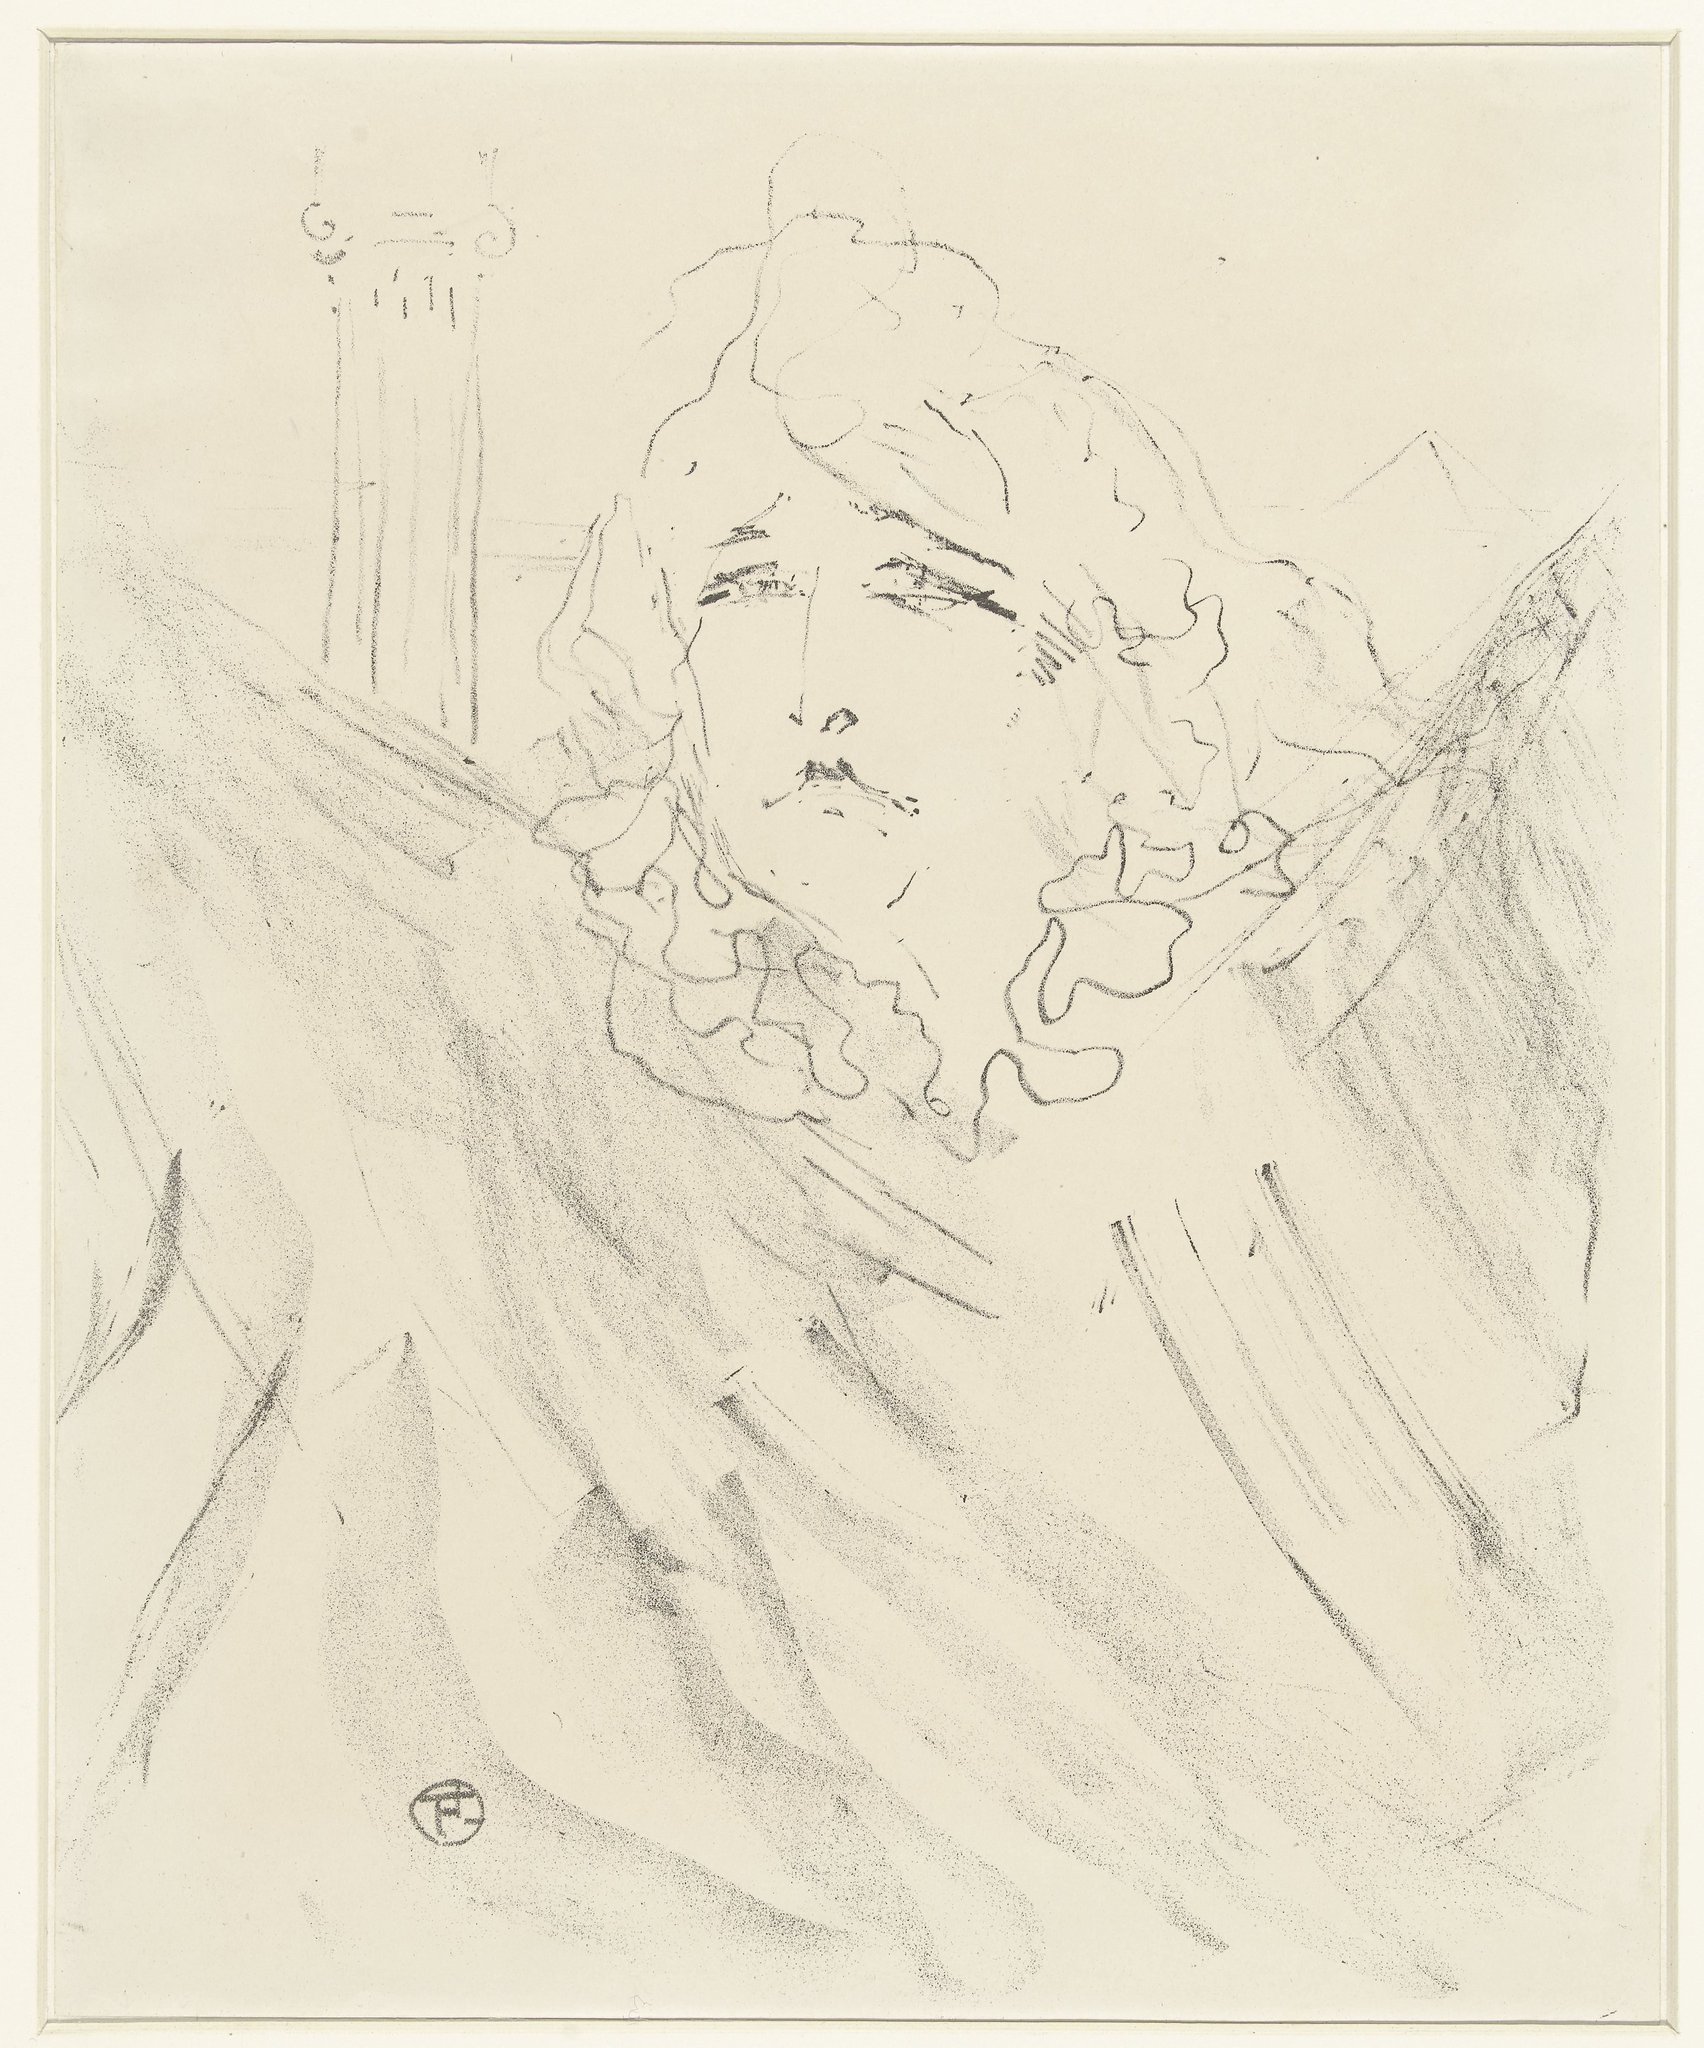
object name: print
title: Portret van actrice Sarah Bernhardt in Cleopâtre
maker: henri de toulouse-lautrec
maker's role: draughtsman, painter, print maker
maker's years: 1864-1901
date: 1898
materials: paper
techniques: lithograph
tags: paris, sarah bernhardt, portrait of actor, actress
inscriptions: collector's mark: Lugt 2760, collector's mark: Lugt 2233, collector's mark: Lugt 2228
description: Uit album met portretten van acteurs en actrices Portraits d'Acteurs & d'Actrices: Treize Lithographies. Oorspronkelijk een initiatief van uitgever W.H.B. Sands maar het album werd met slechts dertien portretten door een onbekende drukker en uitgever vervaardigd. De prent in de collectie van het RMA lijkt een druk uit circa 1913 die verscheen in een oplage van veertig exemplaren op dit formaat (vergelijk Wittrock 1985, p. 574).